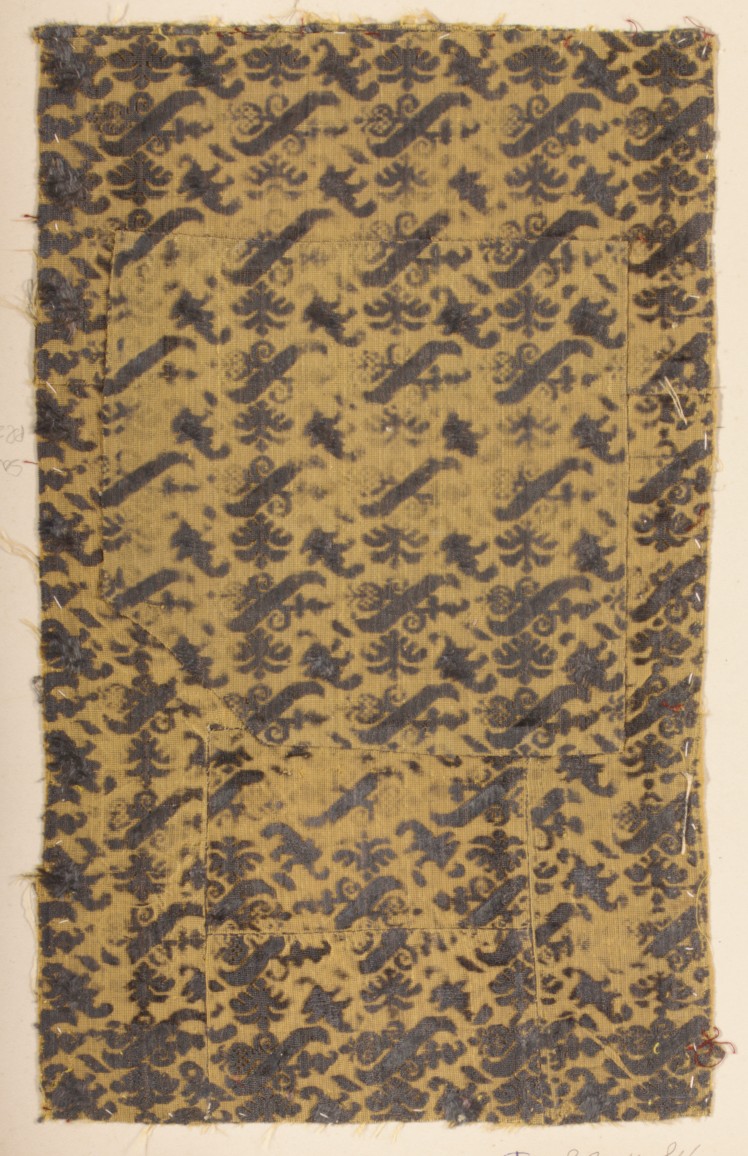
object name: fragment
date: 1501-1600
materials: silk